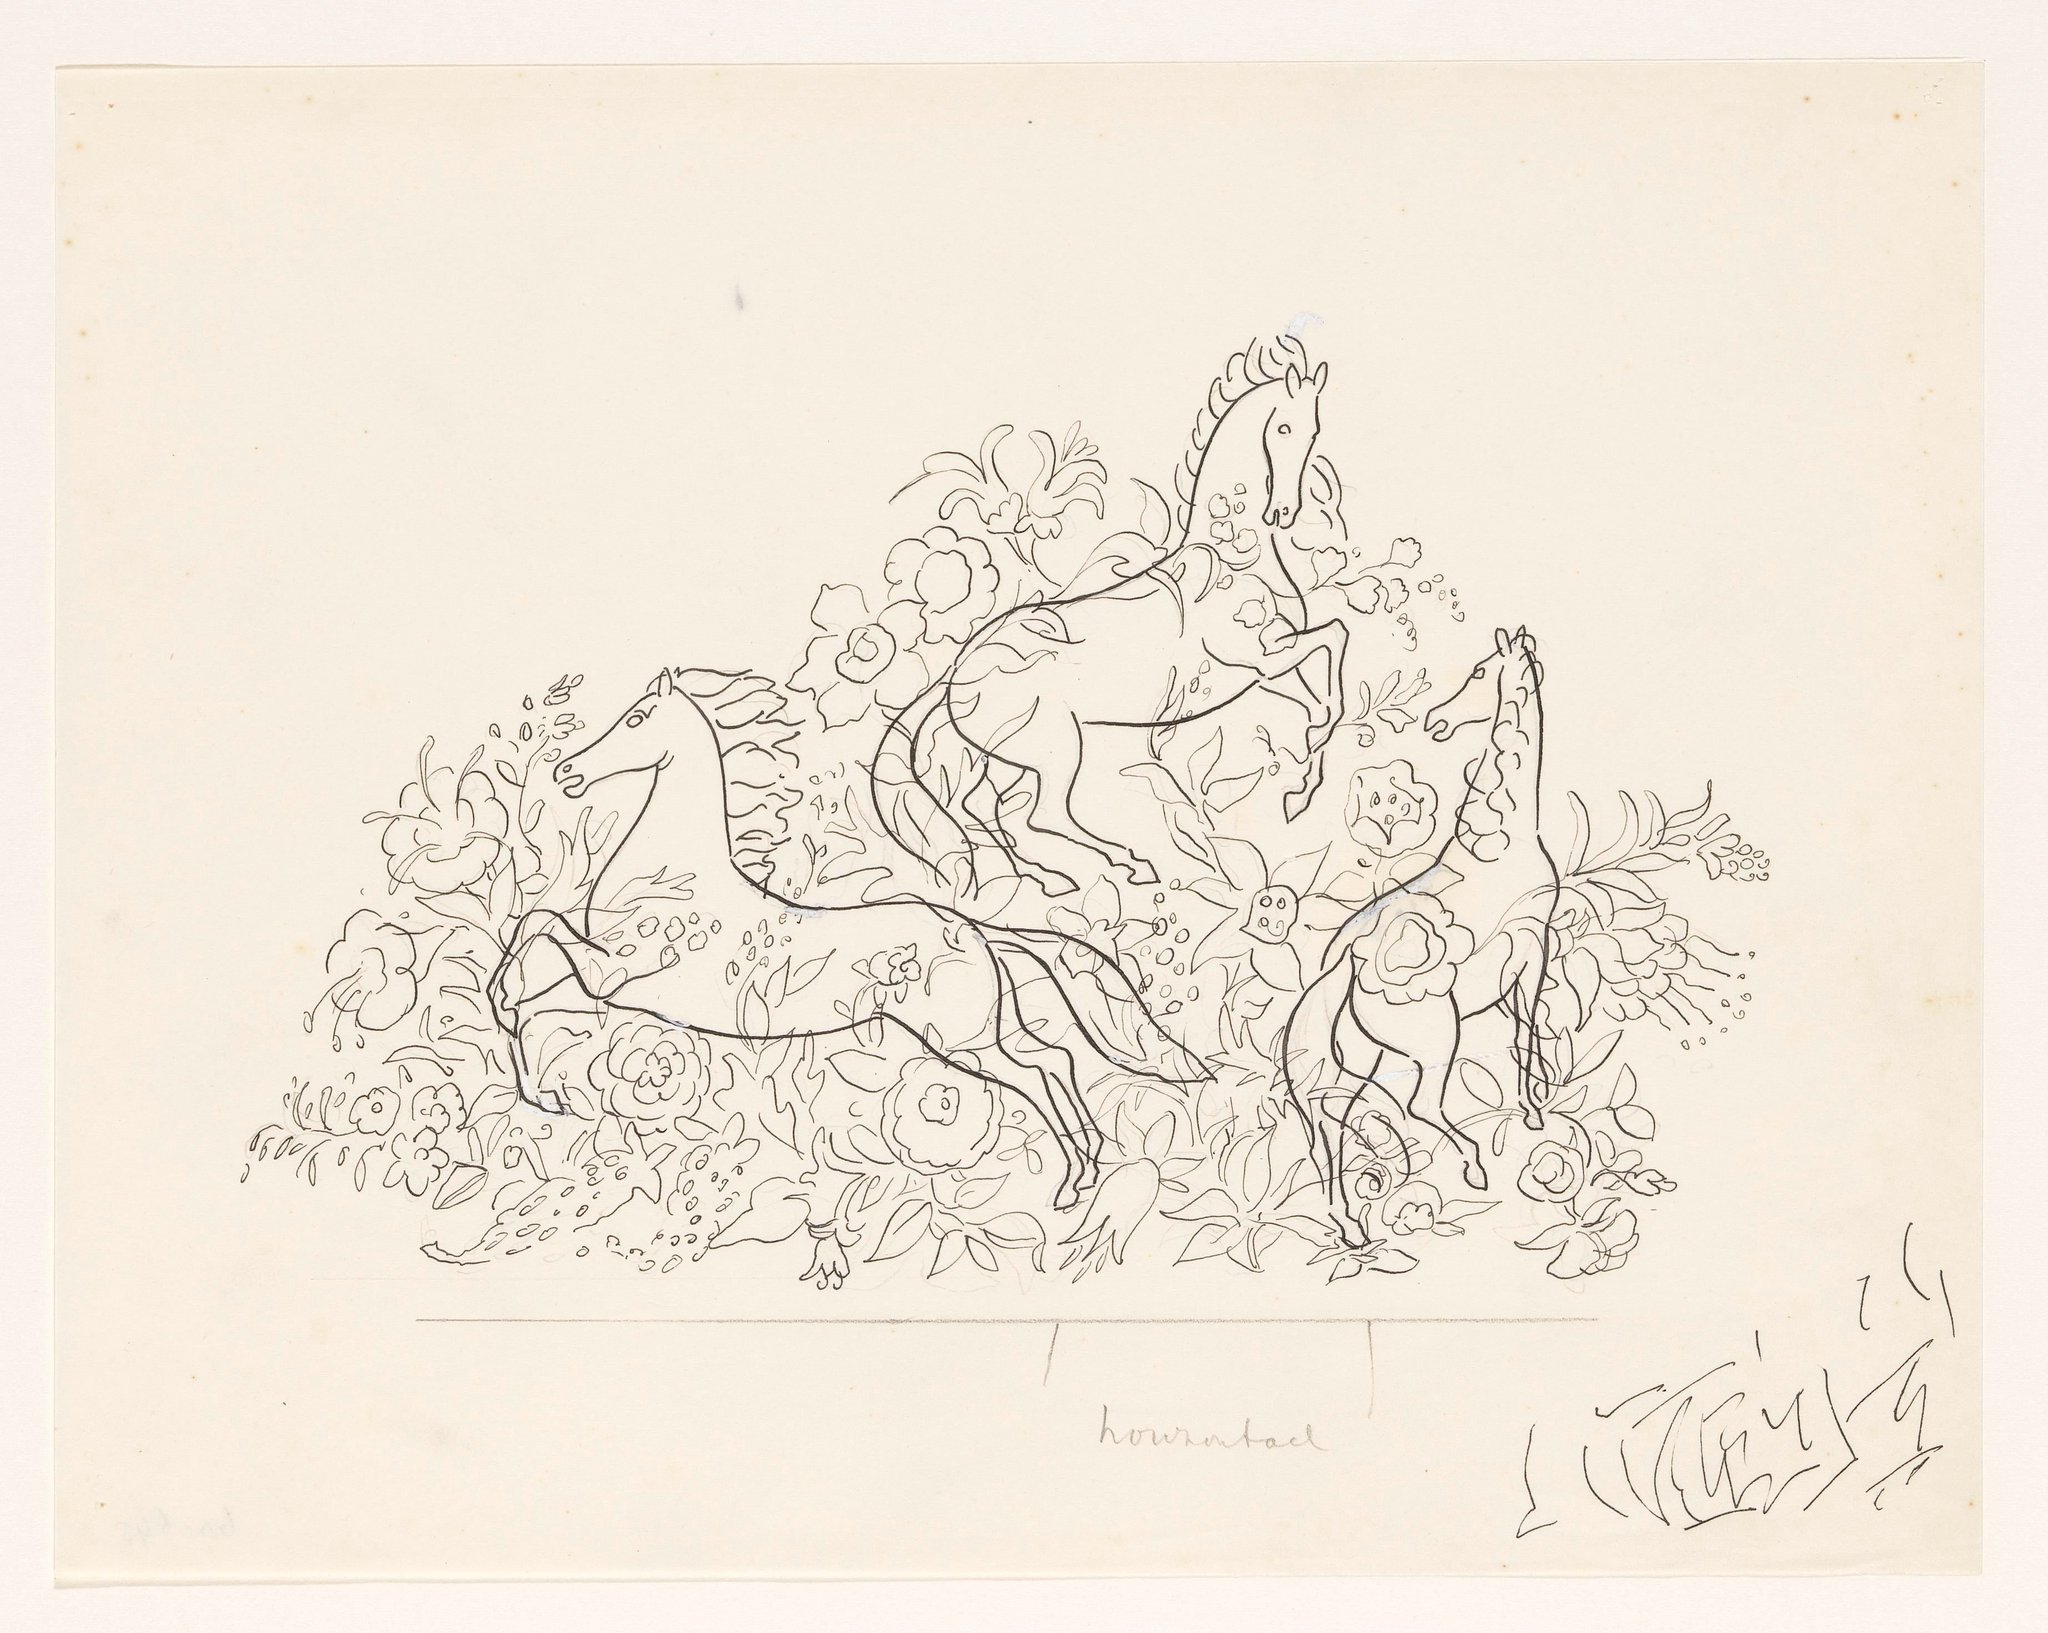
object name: drawing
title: Drie paarden tussen bloemen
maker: leo gestel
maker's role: draughtsman, print maker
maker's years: 1881-1941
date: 1891-1941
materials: paint, ink, paper, pencil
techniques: pen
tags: horse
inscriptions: :, collector's mark: Lugt 2228, watermark: ‘GW/ PAPIER/ 1671’